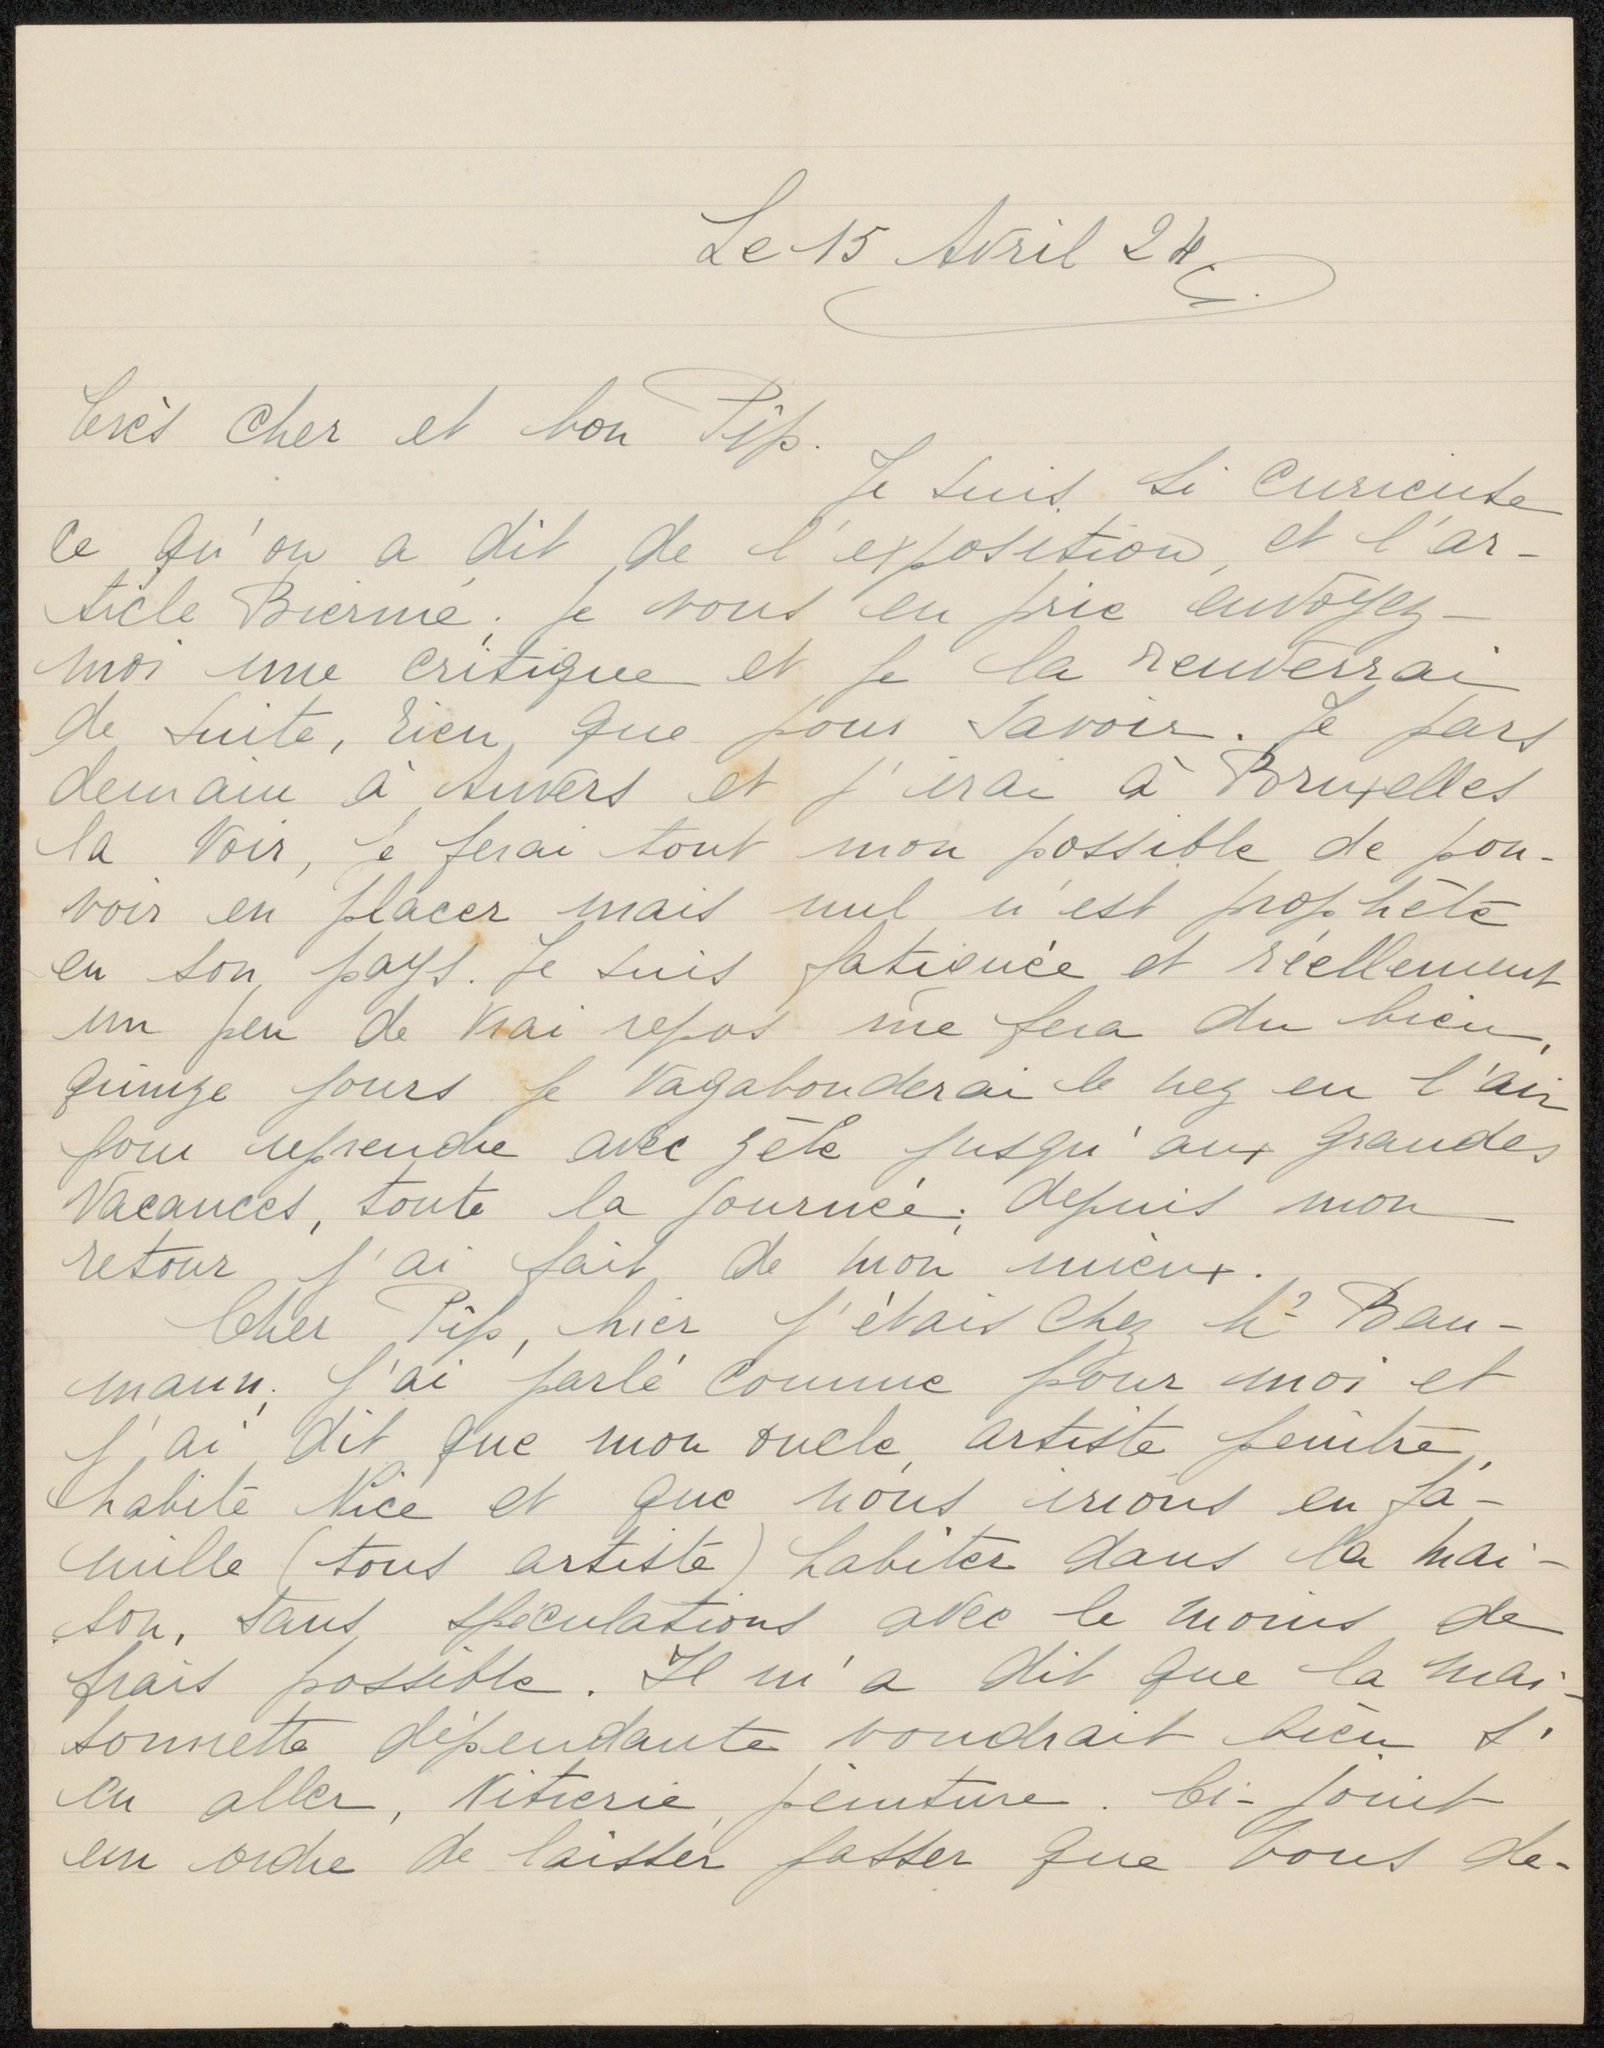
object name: letter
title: Brief aan Philip Zilcken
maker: rose imel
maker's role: draughtsman, painter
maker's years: 1901-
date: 1924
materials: ink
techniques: pen, writing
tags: maria biermé, the hague, philip zilcken, exhibition ~ art, money, printed matter, antwerp, brussels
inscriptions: collector's mark: ‘RPK’